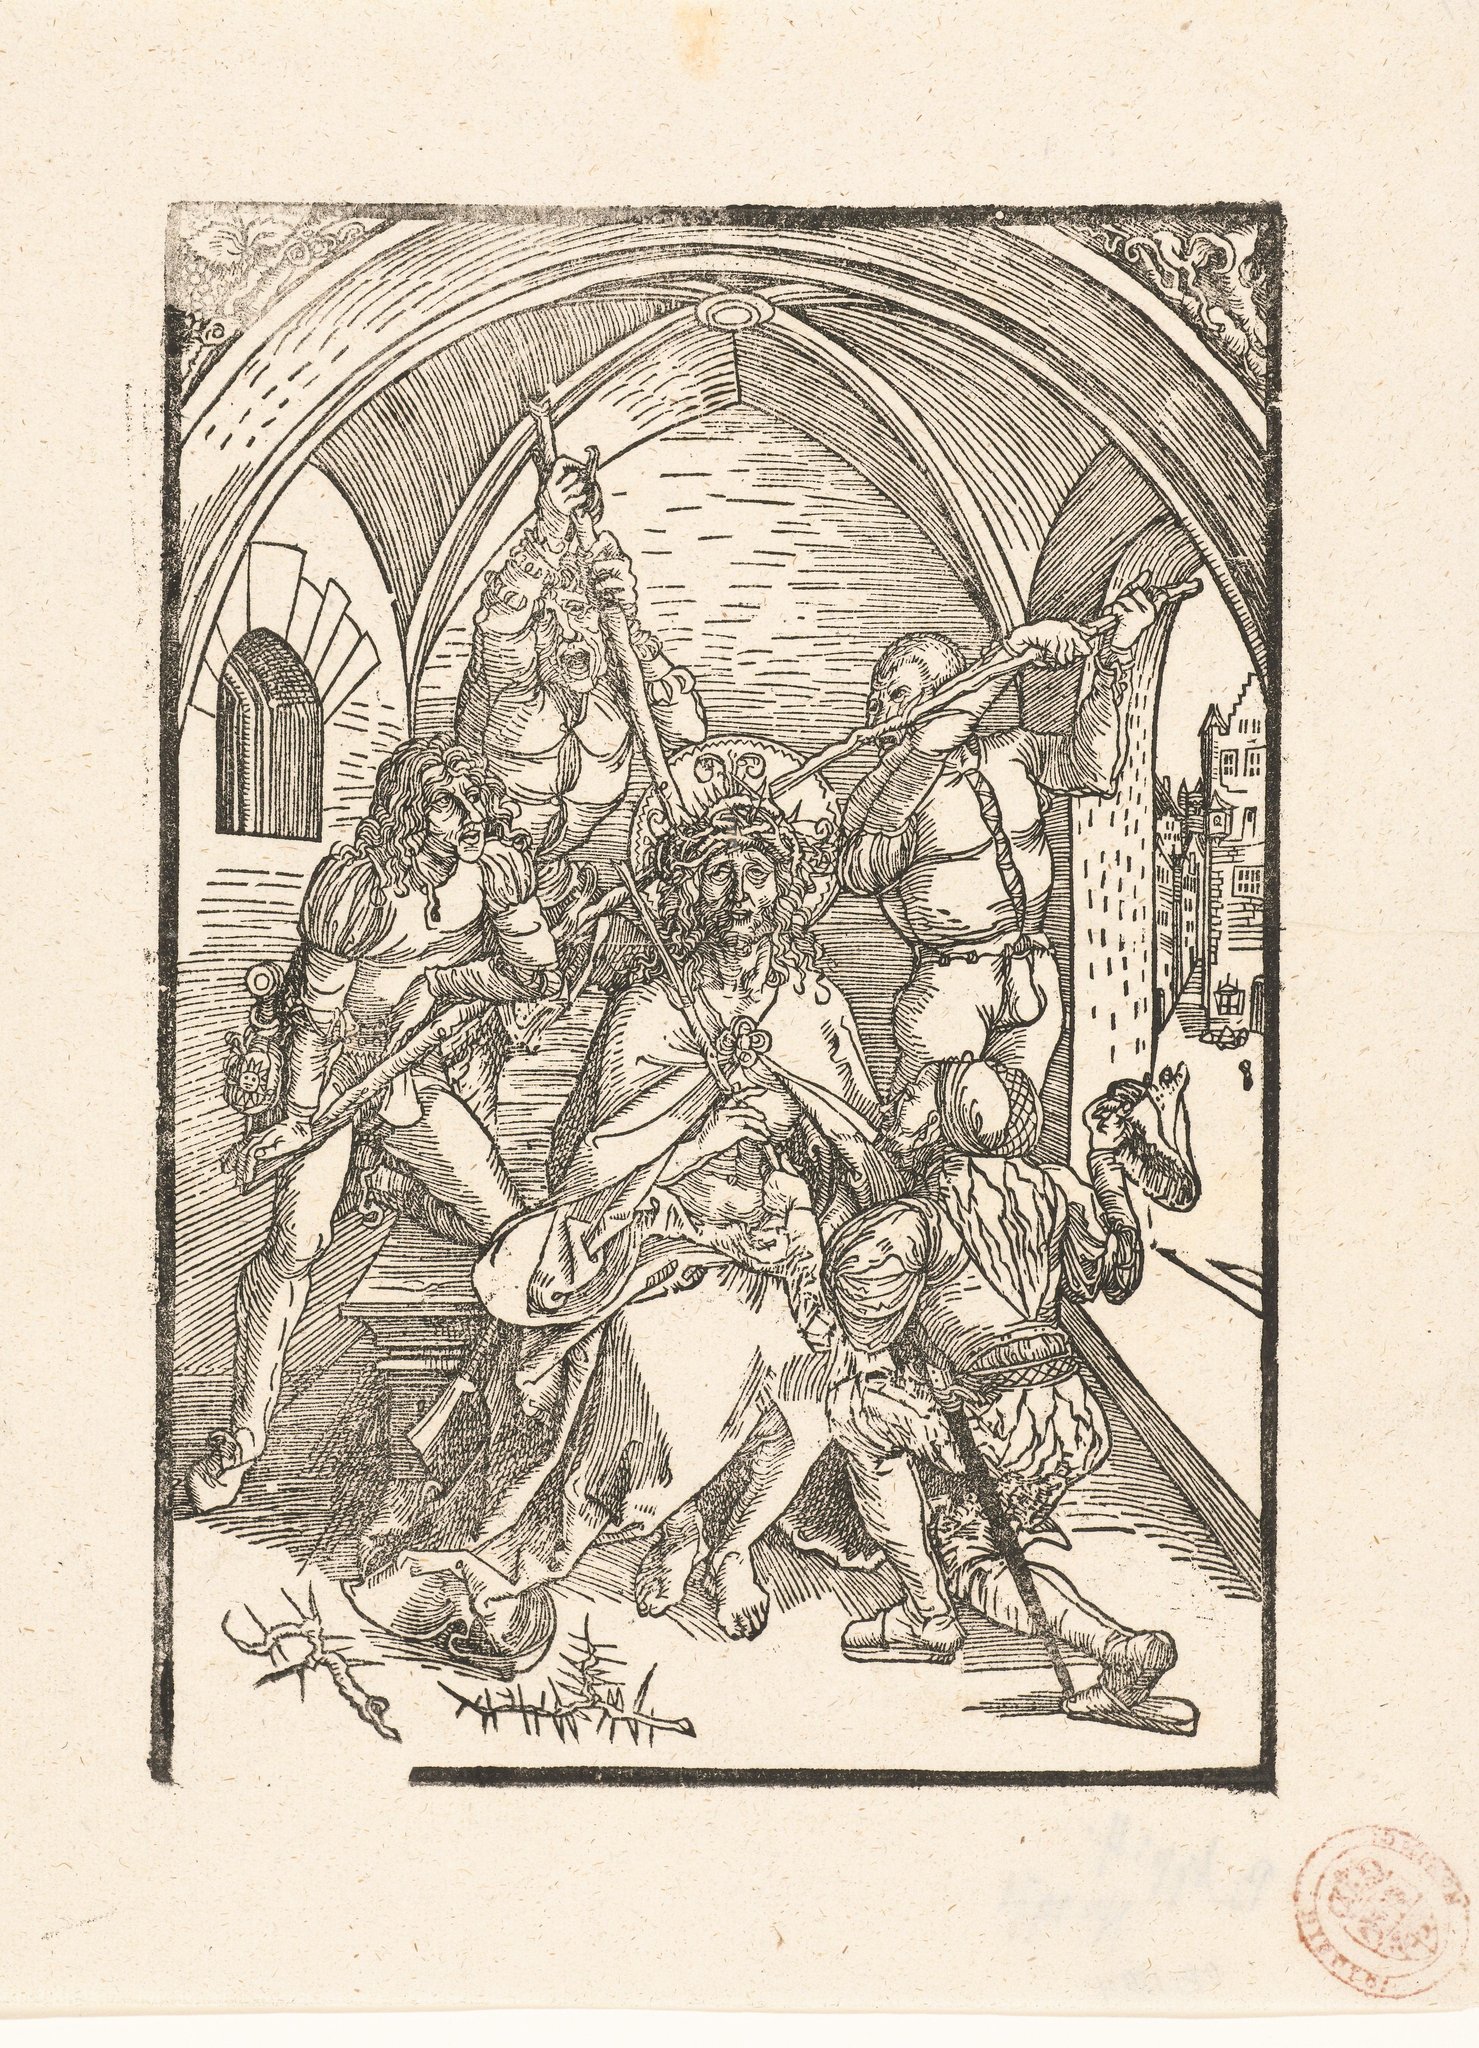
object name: print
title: Doornenkroning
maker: albrecht dürer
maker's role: draughtsman, painter, print maker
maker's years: 1471-1528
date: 1498-1502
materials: paper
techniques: woodcut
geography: nuremberg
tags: the crowning with thorns: soldiers with sticks place a thorny crown on christ's head and give him a reed (matthew 27:27-31; mark 15:16-20; john 19:2-3)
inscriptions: collector's mark: Lugt 240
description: Christus, zittend op een verhoging, krijgt een doornenkroon op het hoofd geduwd. Deze prent is onderdeel van de zogenoemde 'Albertina Passie', een onvoltooide passiereeks (4 prenten).